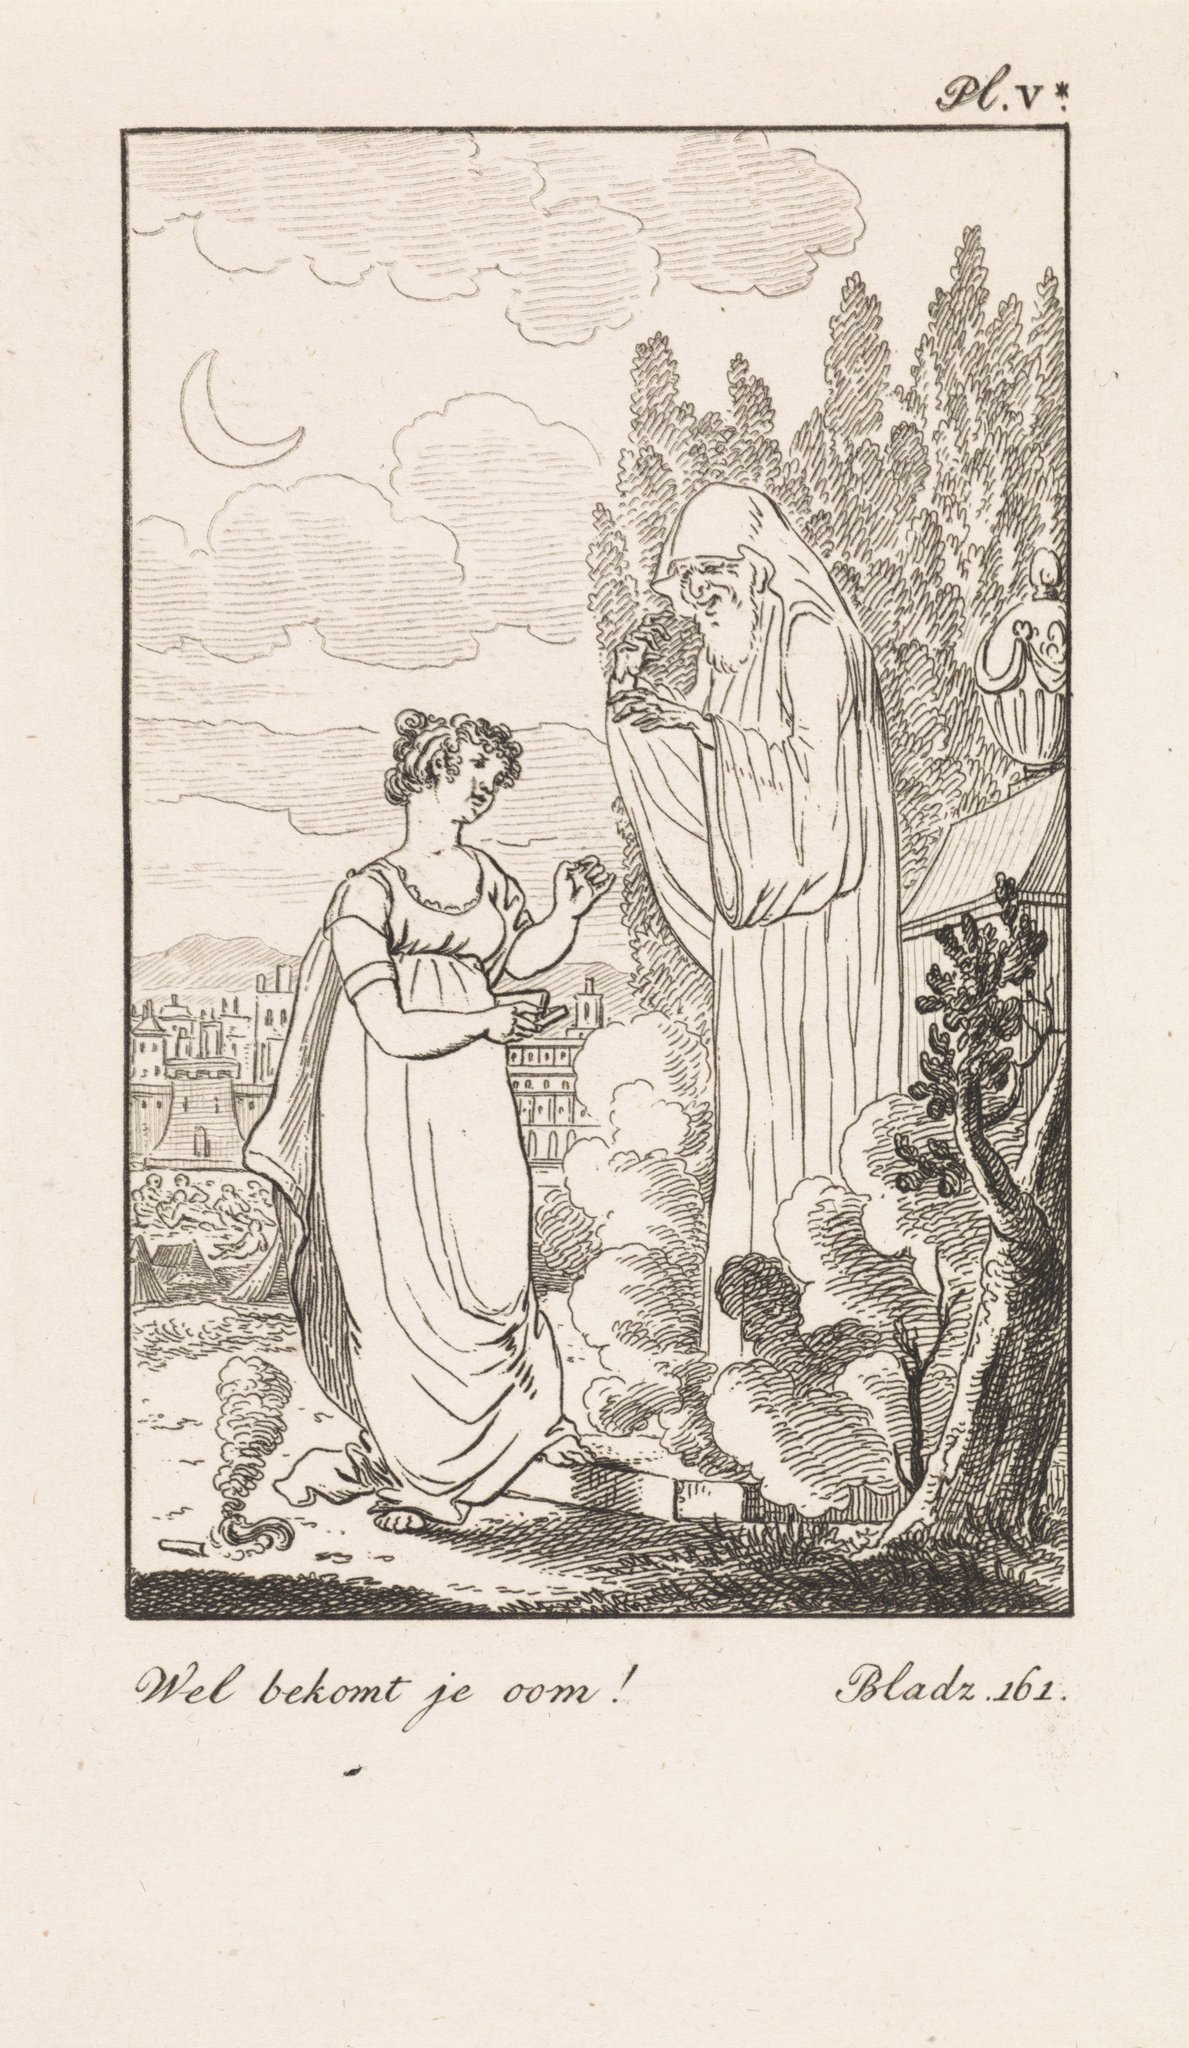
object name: print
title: Wel bekomt je oom!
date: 1802-1809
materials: paper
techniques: etching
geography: haarlem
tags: spirit, ghost, political caricatures and satires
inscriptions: collector's mark: Lugt 2228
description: Prent als boekillustratie gebruikt in: Fokke Simonsz., Arend. Het hoekjen van den haard of Historie van Frankrijk. Deel IV-VII uit: Boertige Reis door Europa. 7 dln. Haarlem: François Bohn, 1802-1809.